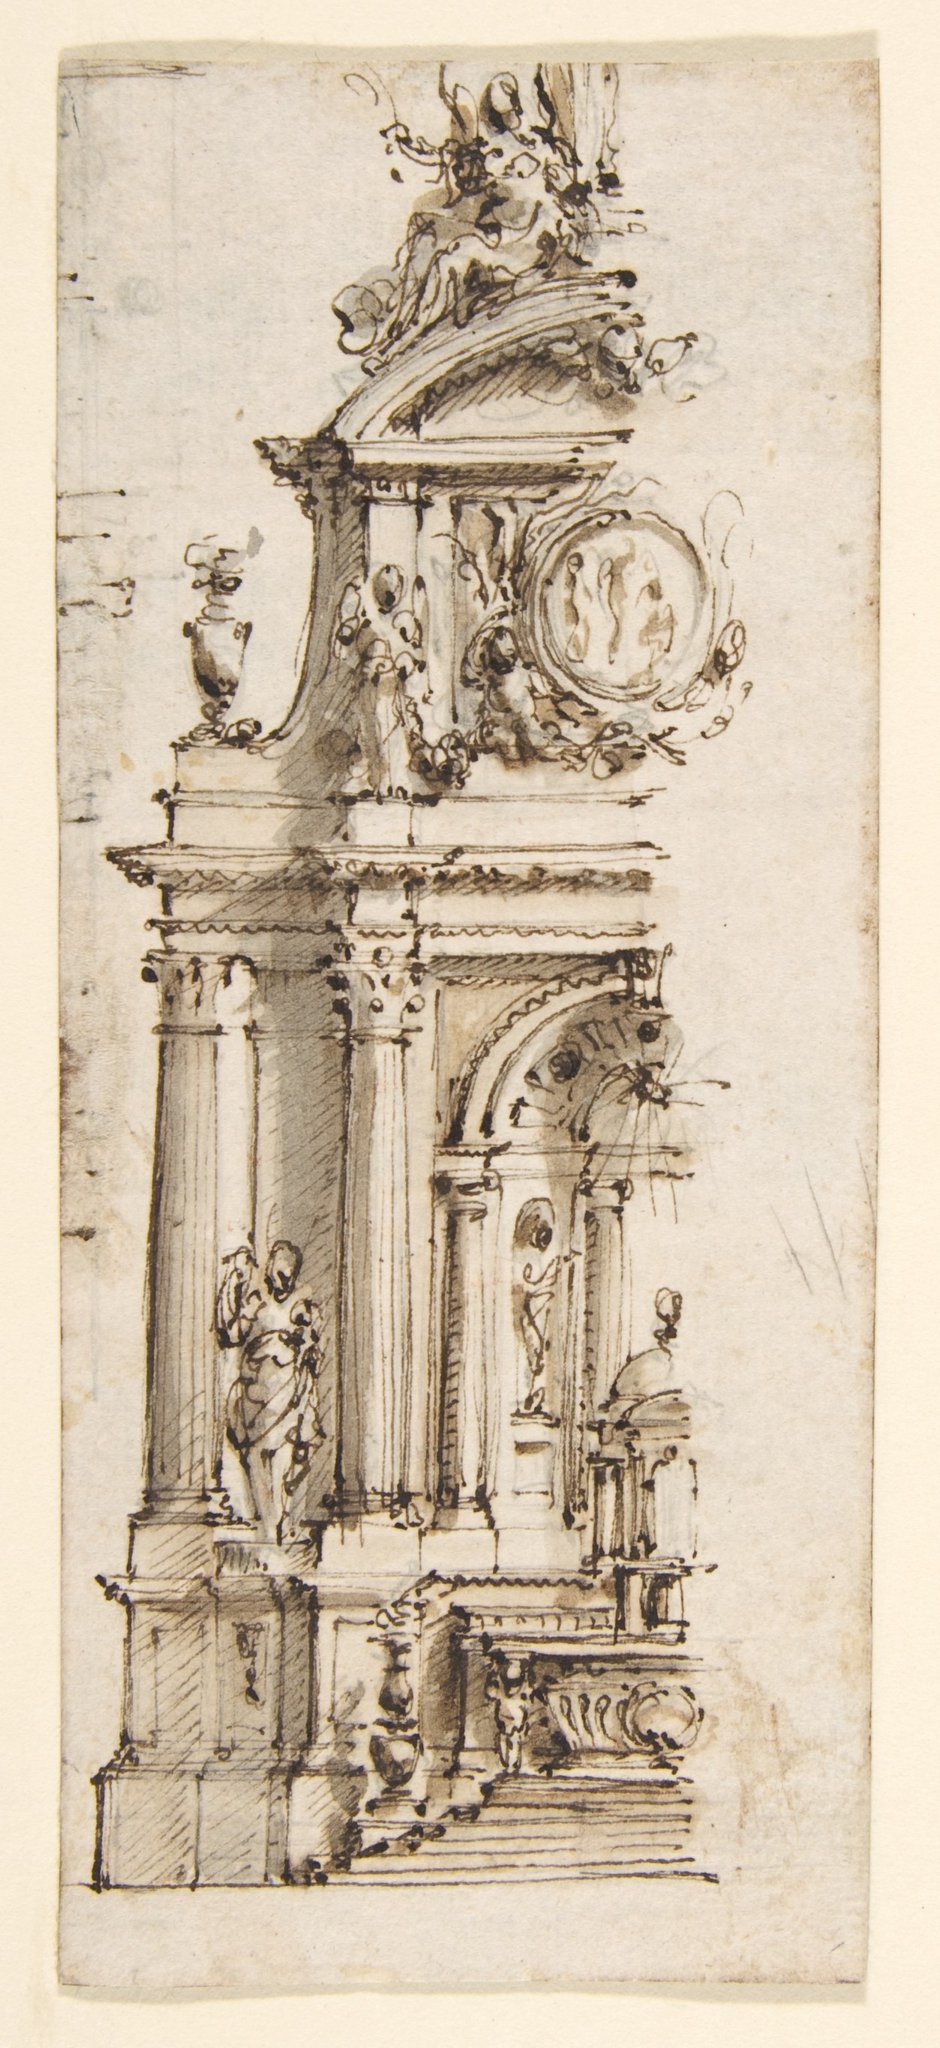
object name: drawing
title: Design for the Left Half of an Altar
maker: mauro antonio tesi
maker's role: artist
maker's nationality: italian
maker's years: 1730-1766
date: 1750-1766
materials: ink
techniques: brush, pen, wash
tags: altars